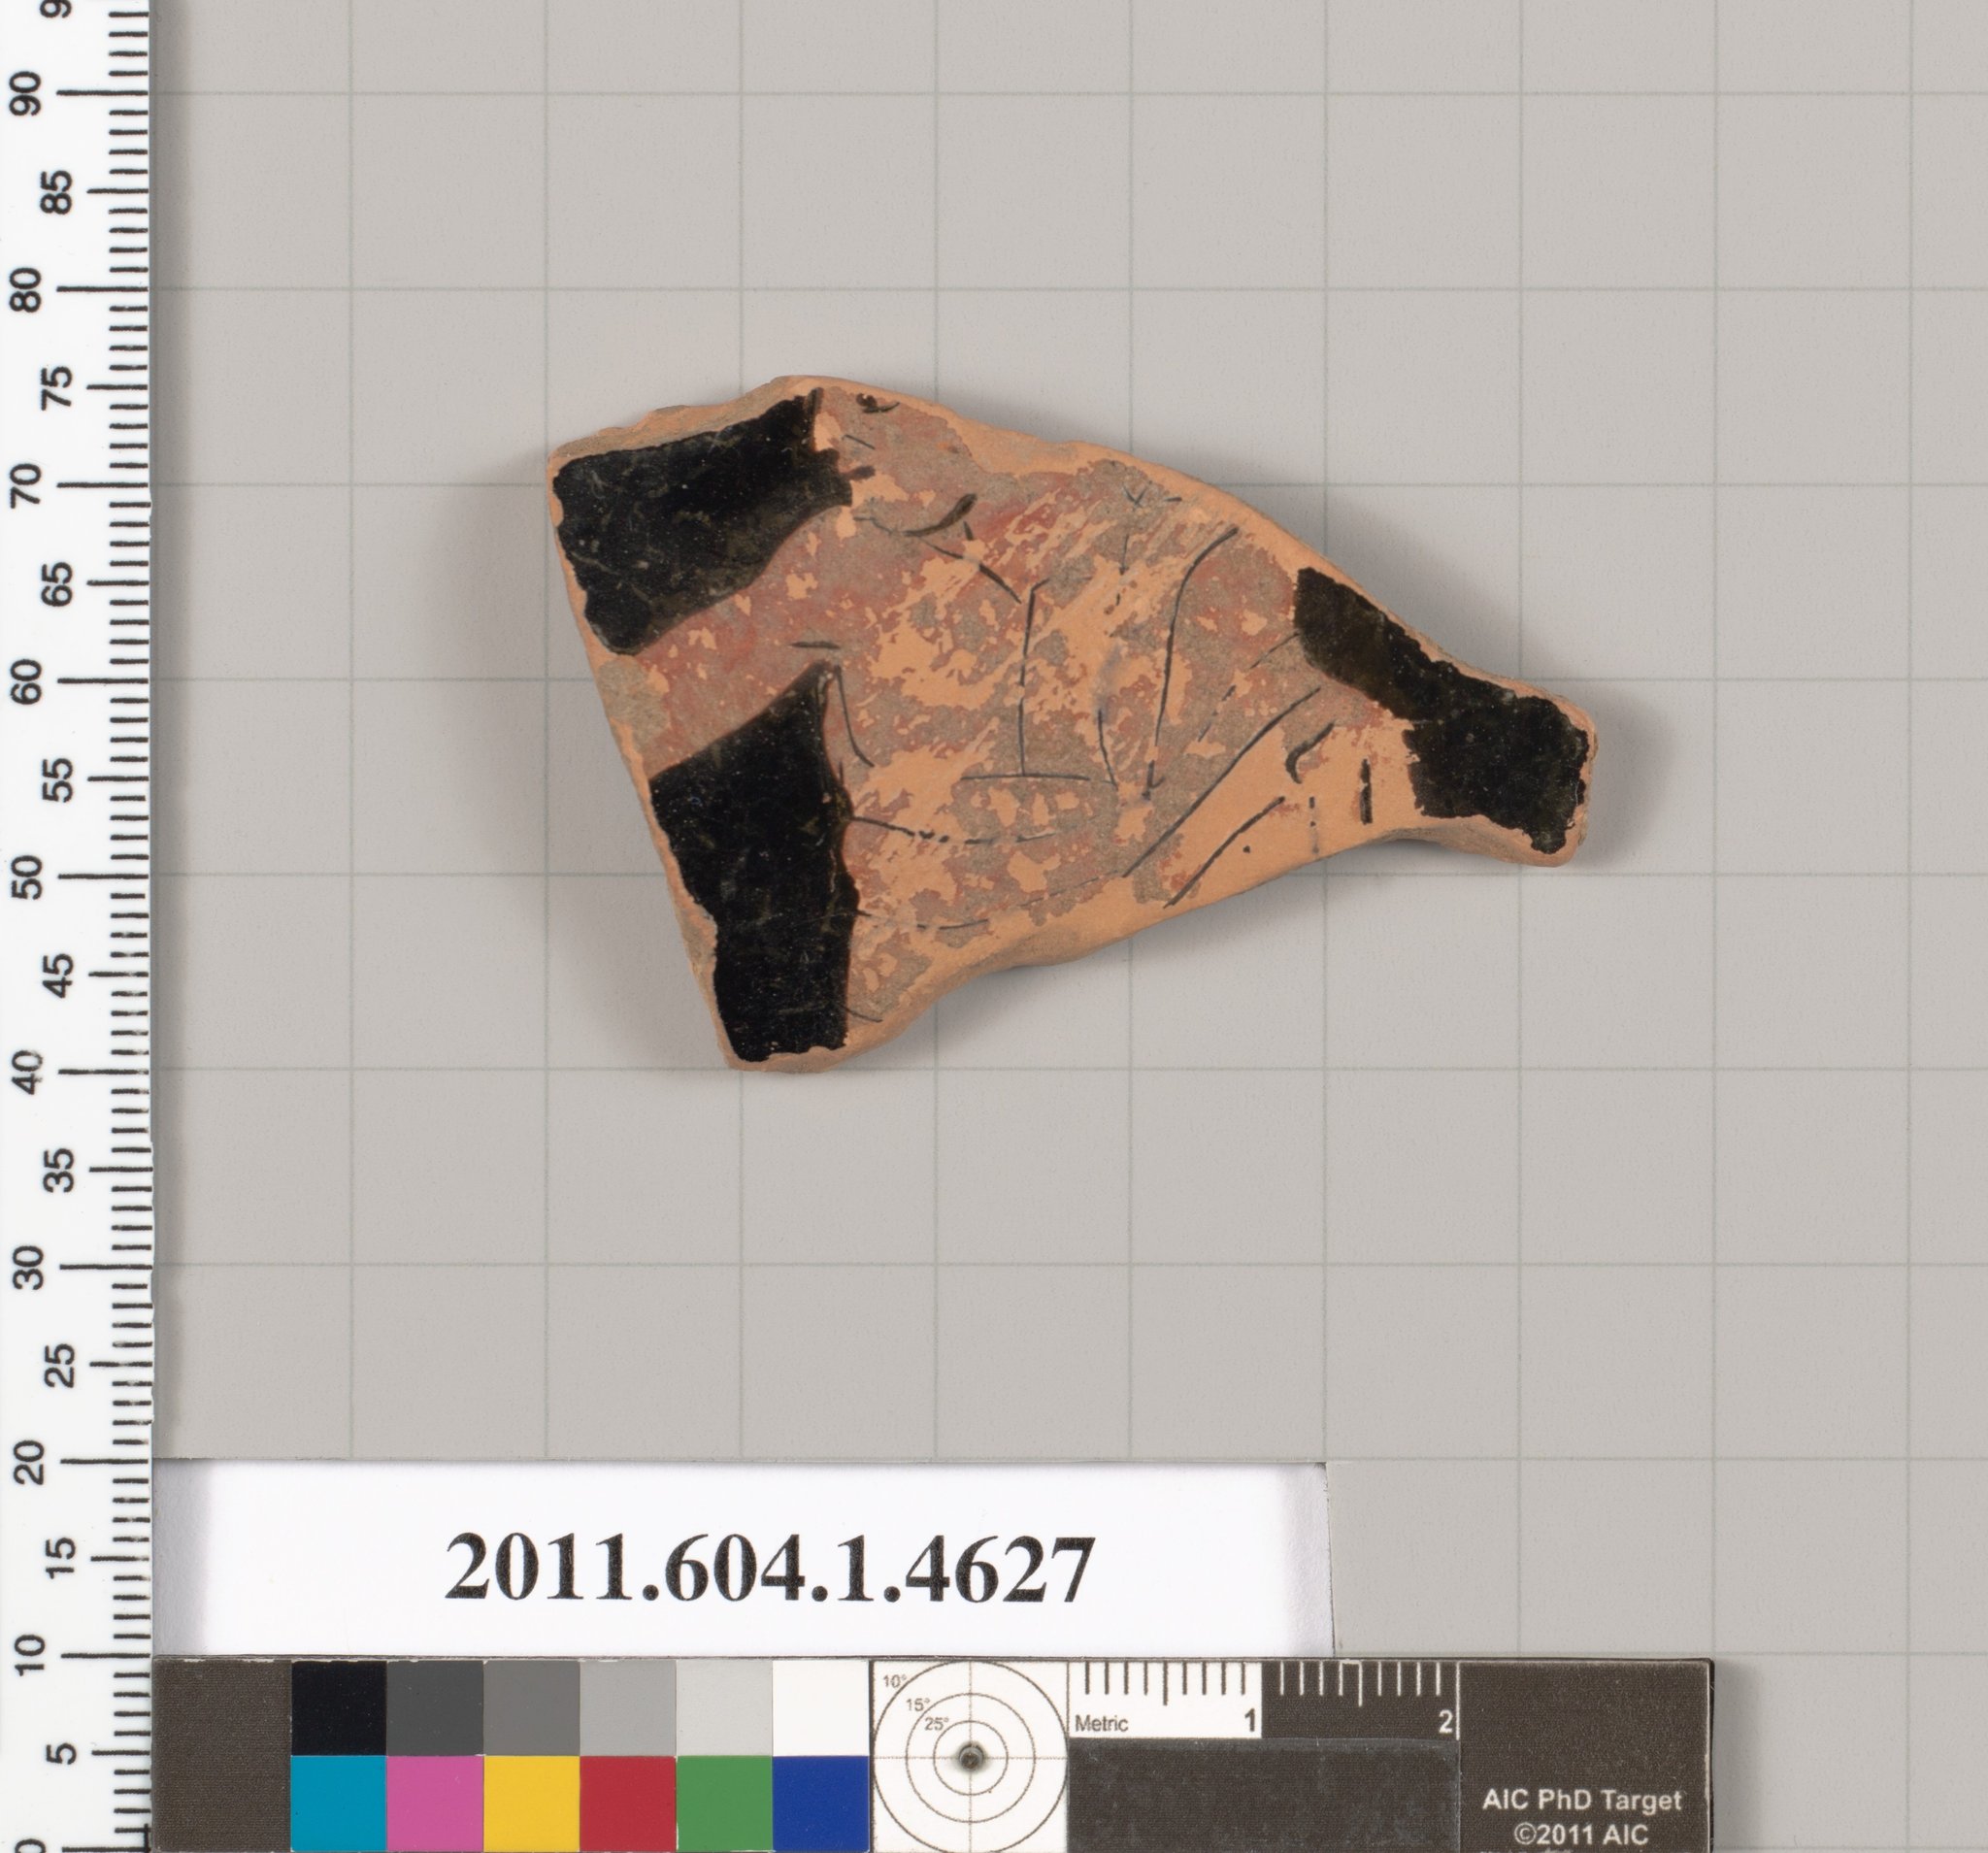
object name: kylix fragment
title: Terracotta fragment of a kylix (drinking cup)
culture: greek, attic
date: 480-470 BCE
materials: terracotta